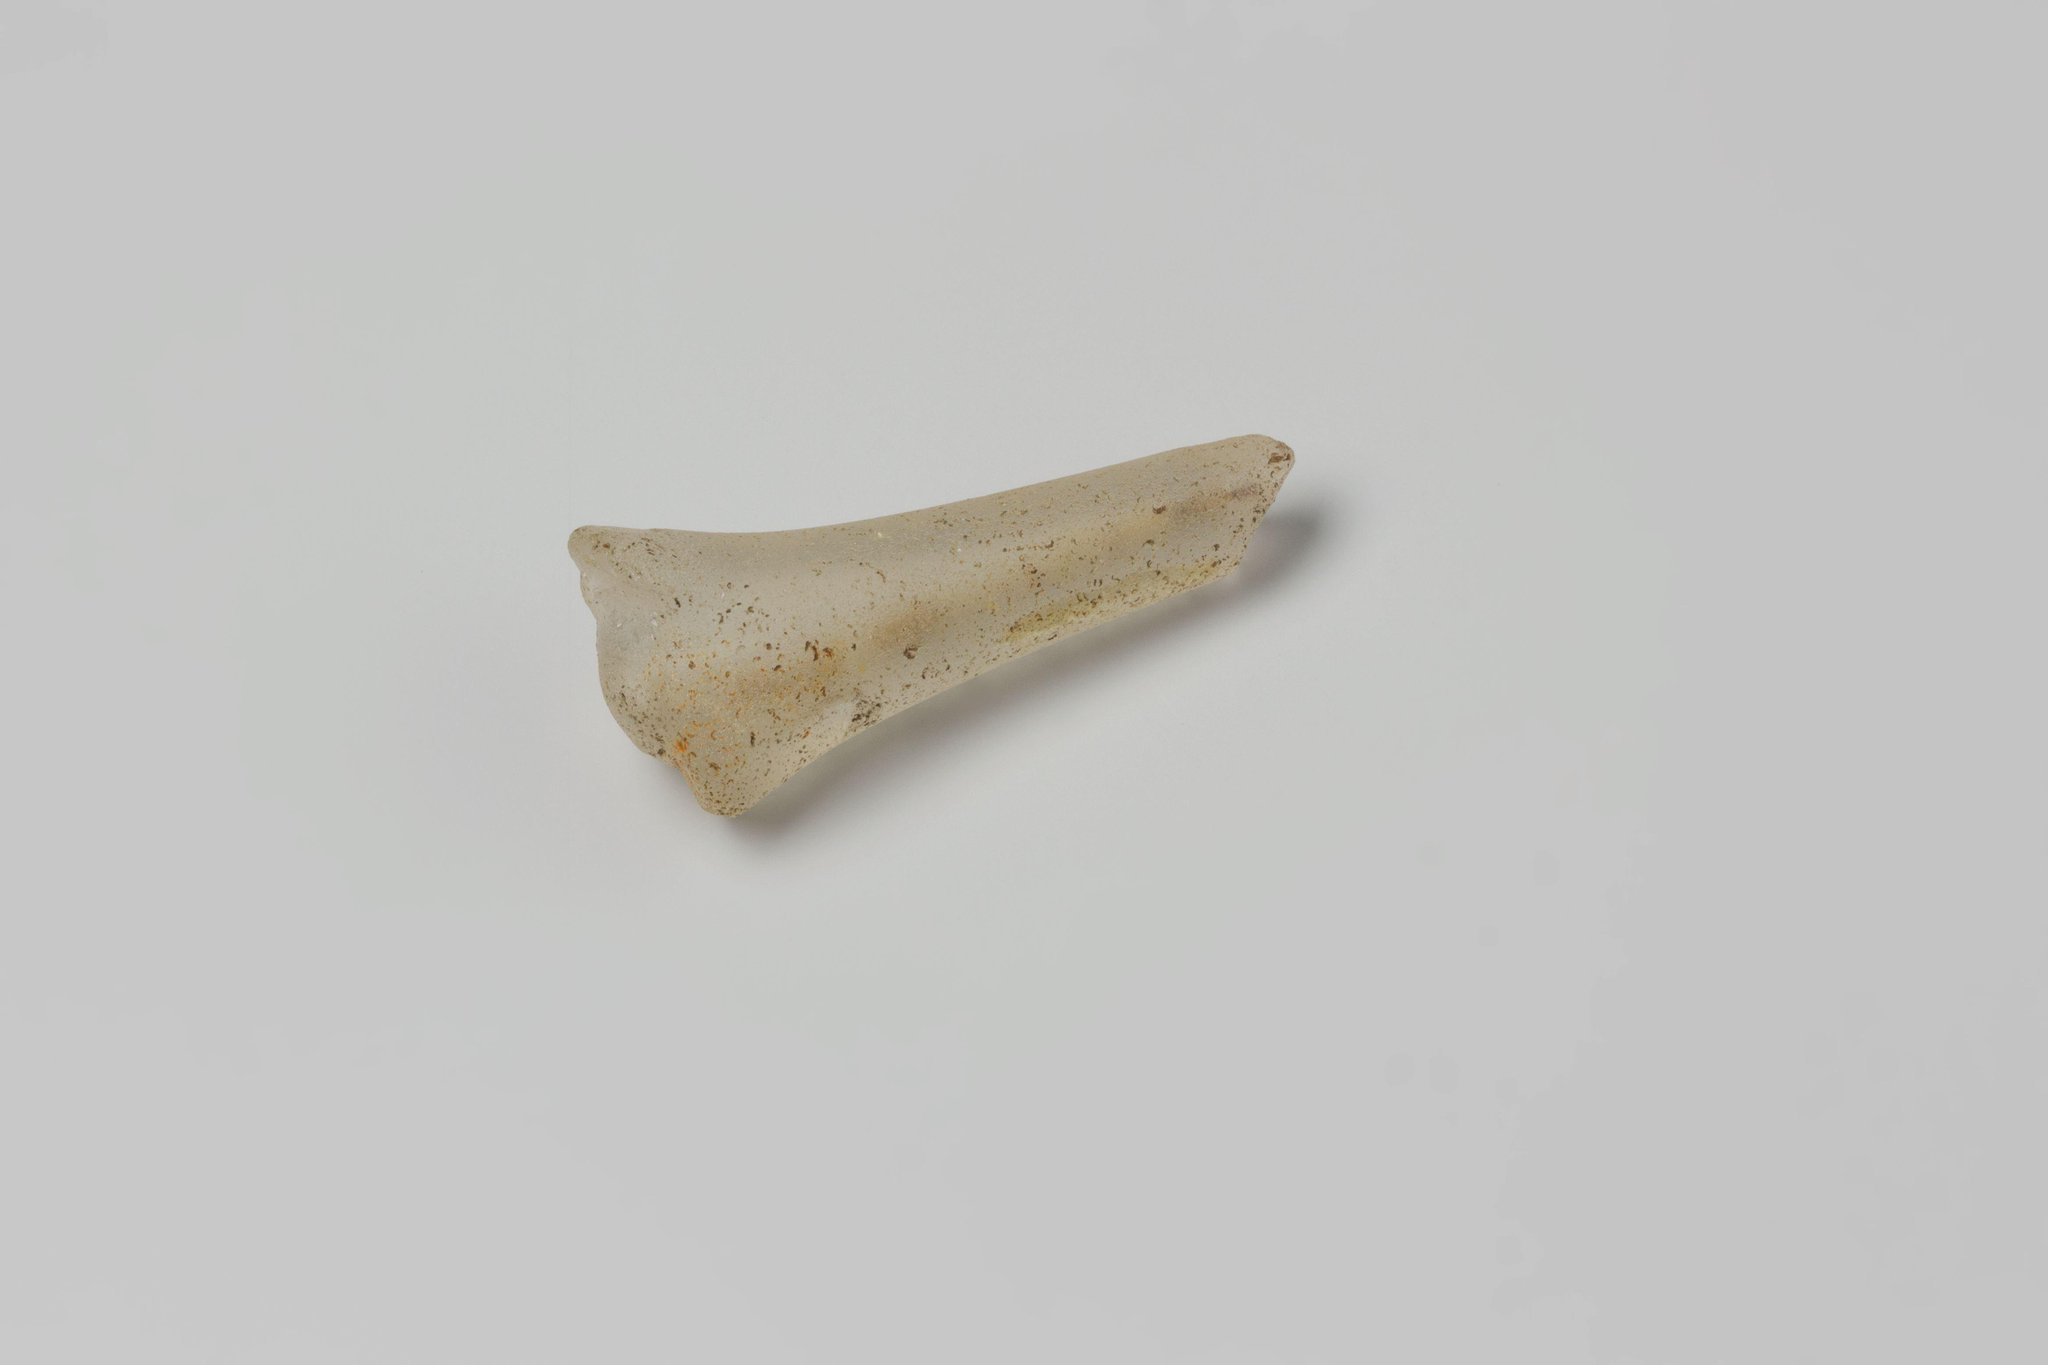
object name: helve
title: Fragment rechte steel van glas uit het wrak van de Oost-Indiëvaarder Hollandia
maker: Anonymous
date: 1700-1743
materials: glass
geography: netherlands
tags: verenigde oostindische compagnie, hollandia (schip), annet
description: Glass, stem glass, stems, plain; fragm, id. NG 1980-27H798.